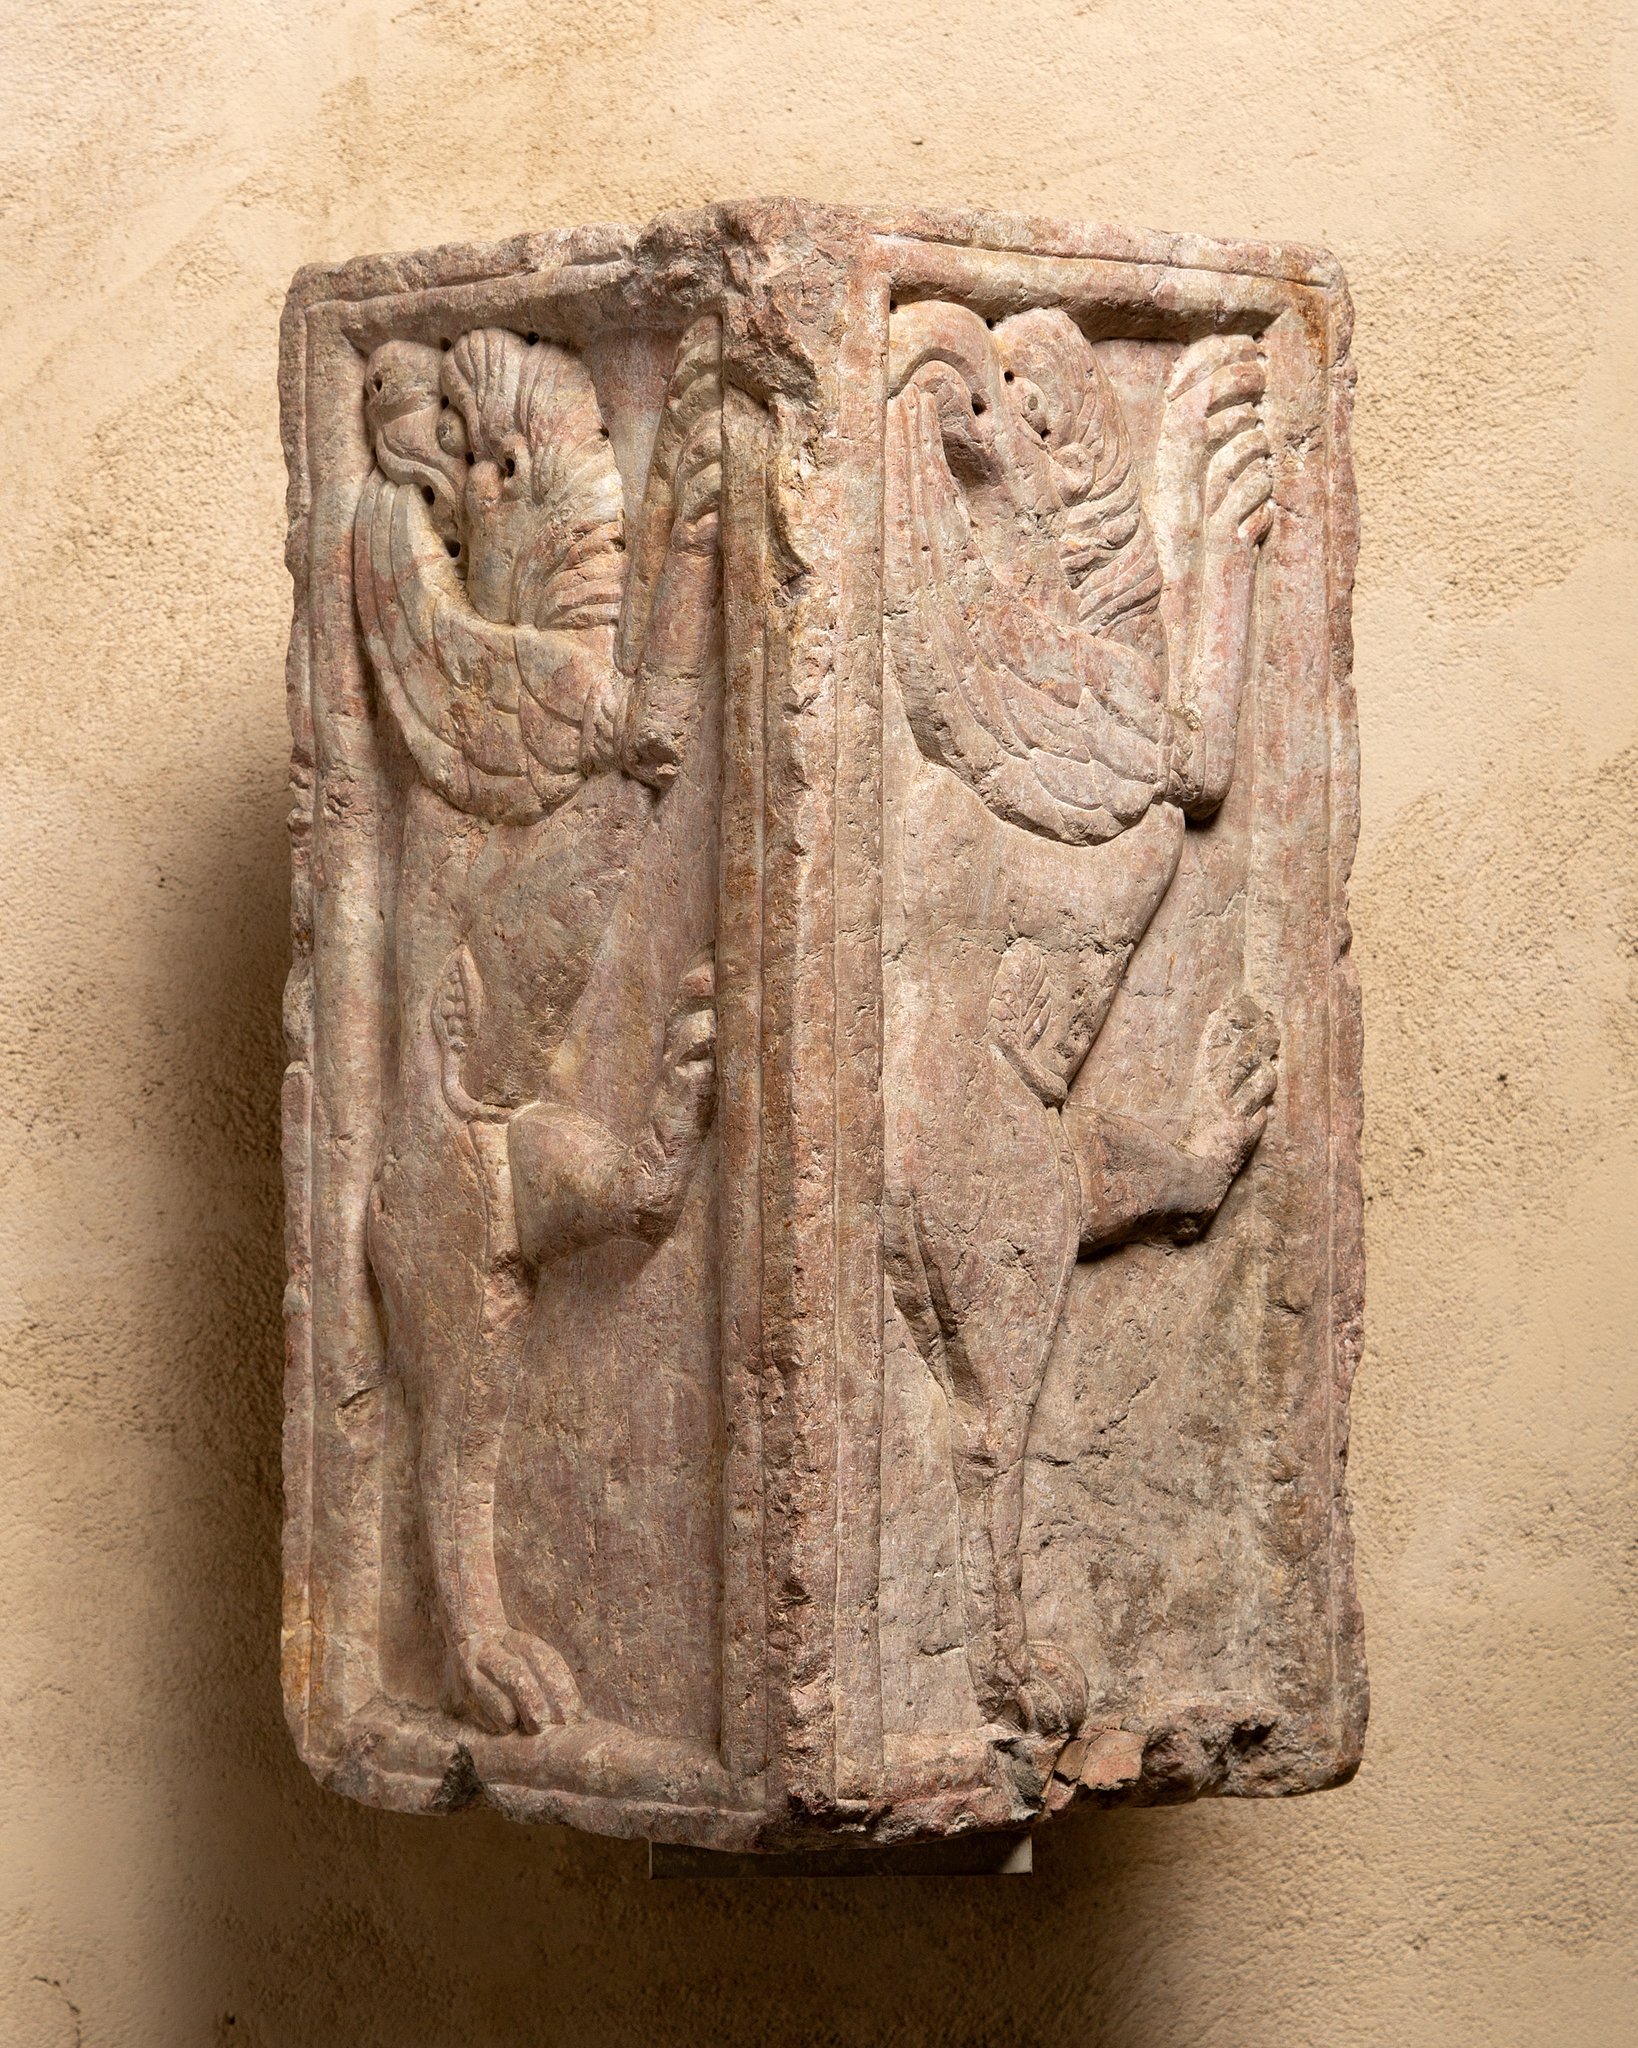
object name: block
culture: catalan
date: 1130-1140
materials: marble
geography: france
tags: griffins